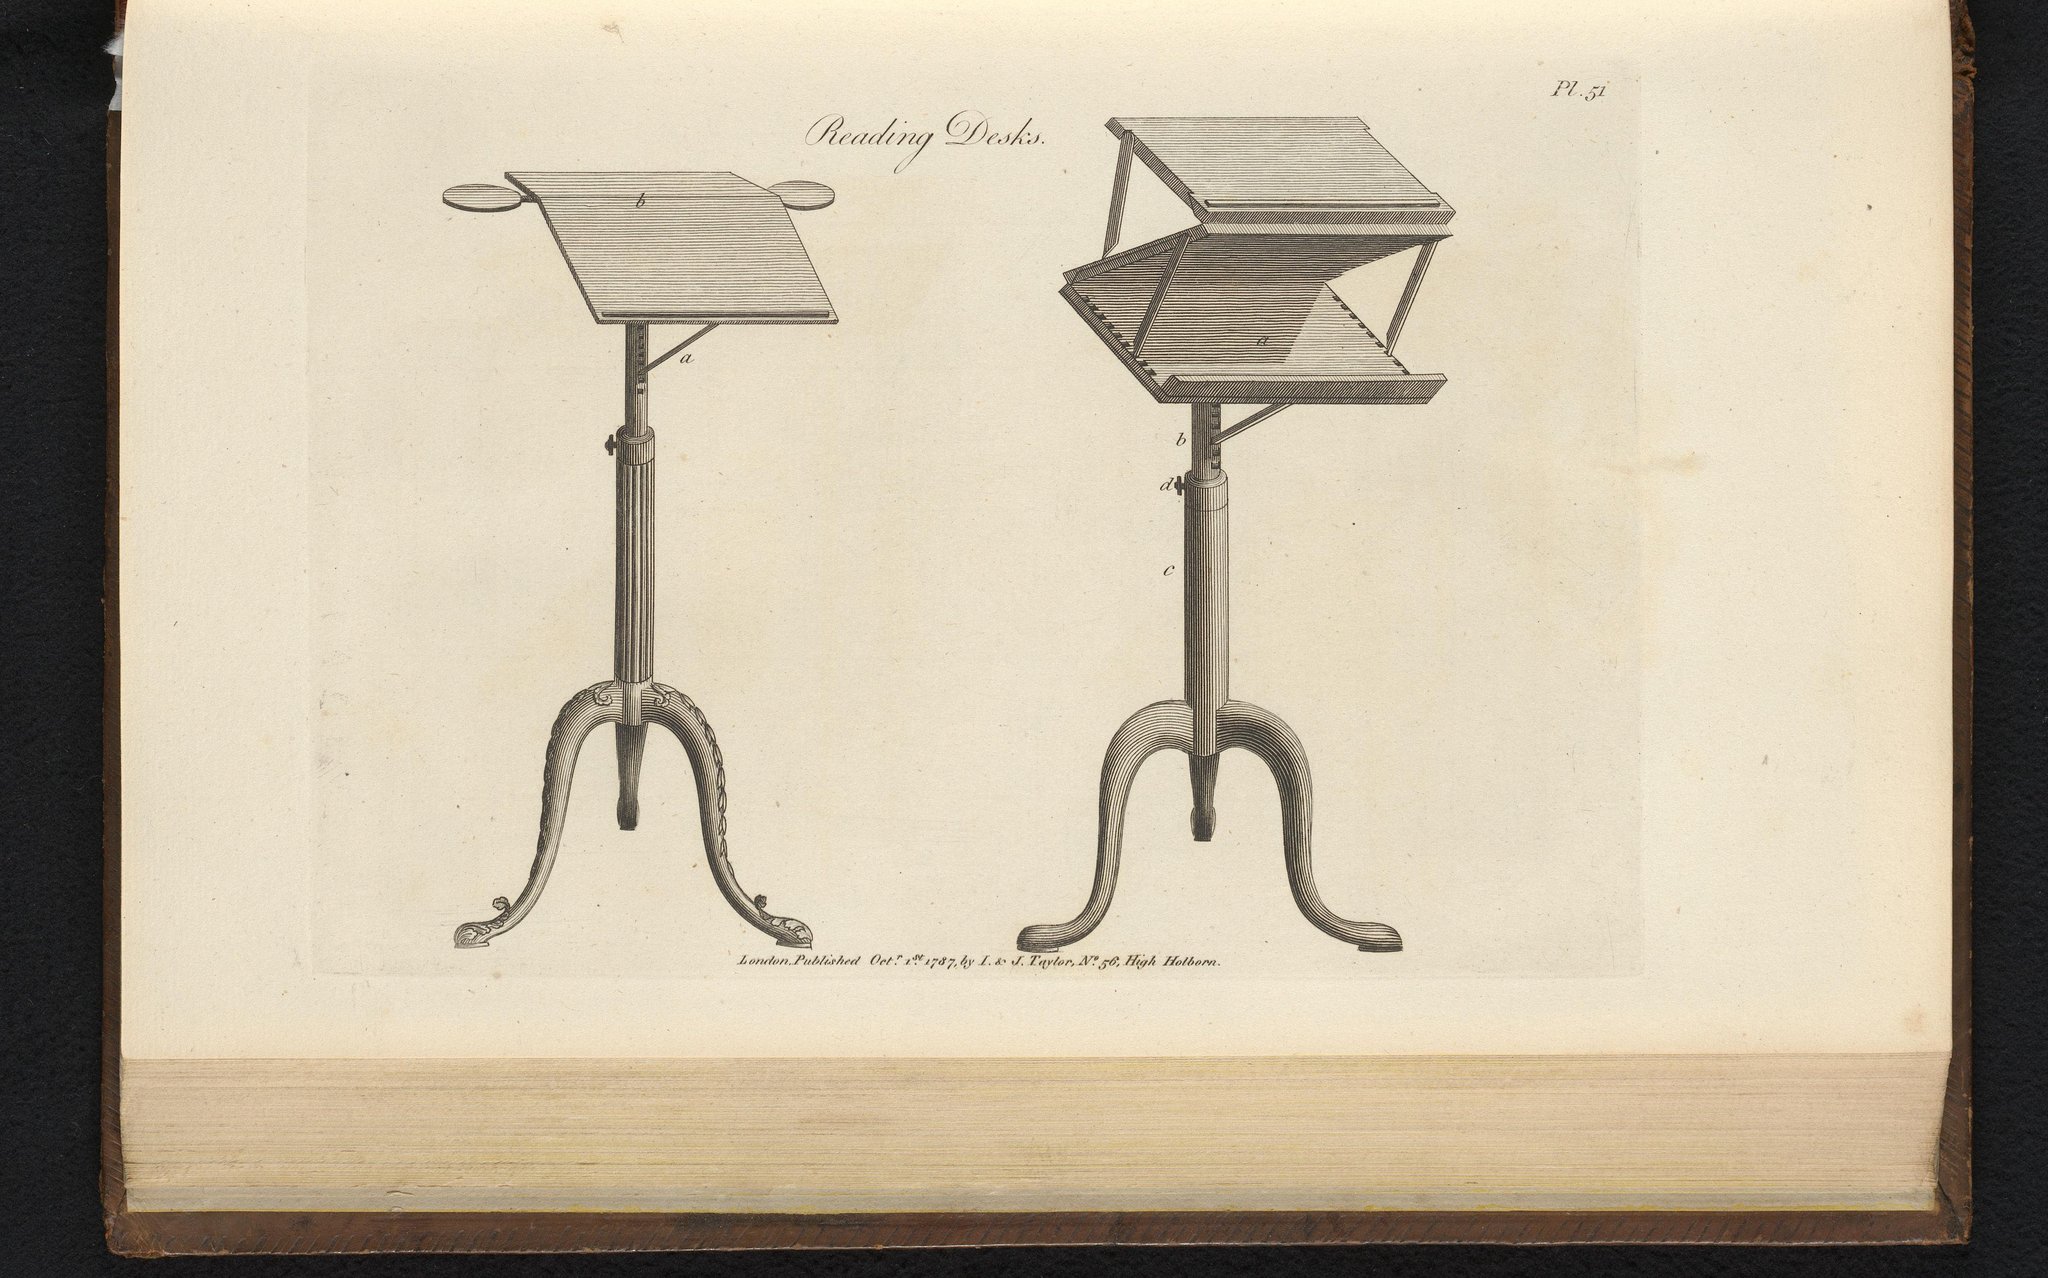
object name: print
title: Reading Desks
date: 1787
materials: paper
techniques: engraving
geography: holborn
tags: lectern ~ reading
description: Genummerd: Pl. 51. Onderdelen lessenaars of leestafels gemerkt als: b, a, c, en d. Prent maakt deel uit van een boek.